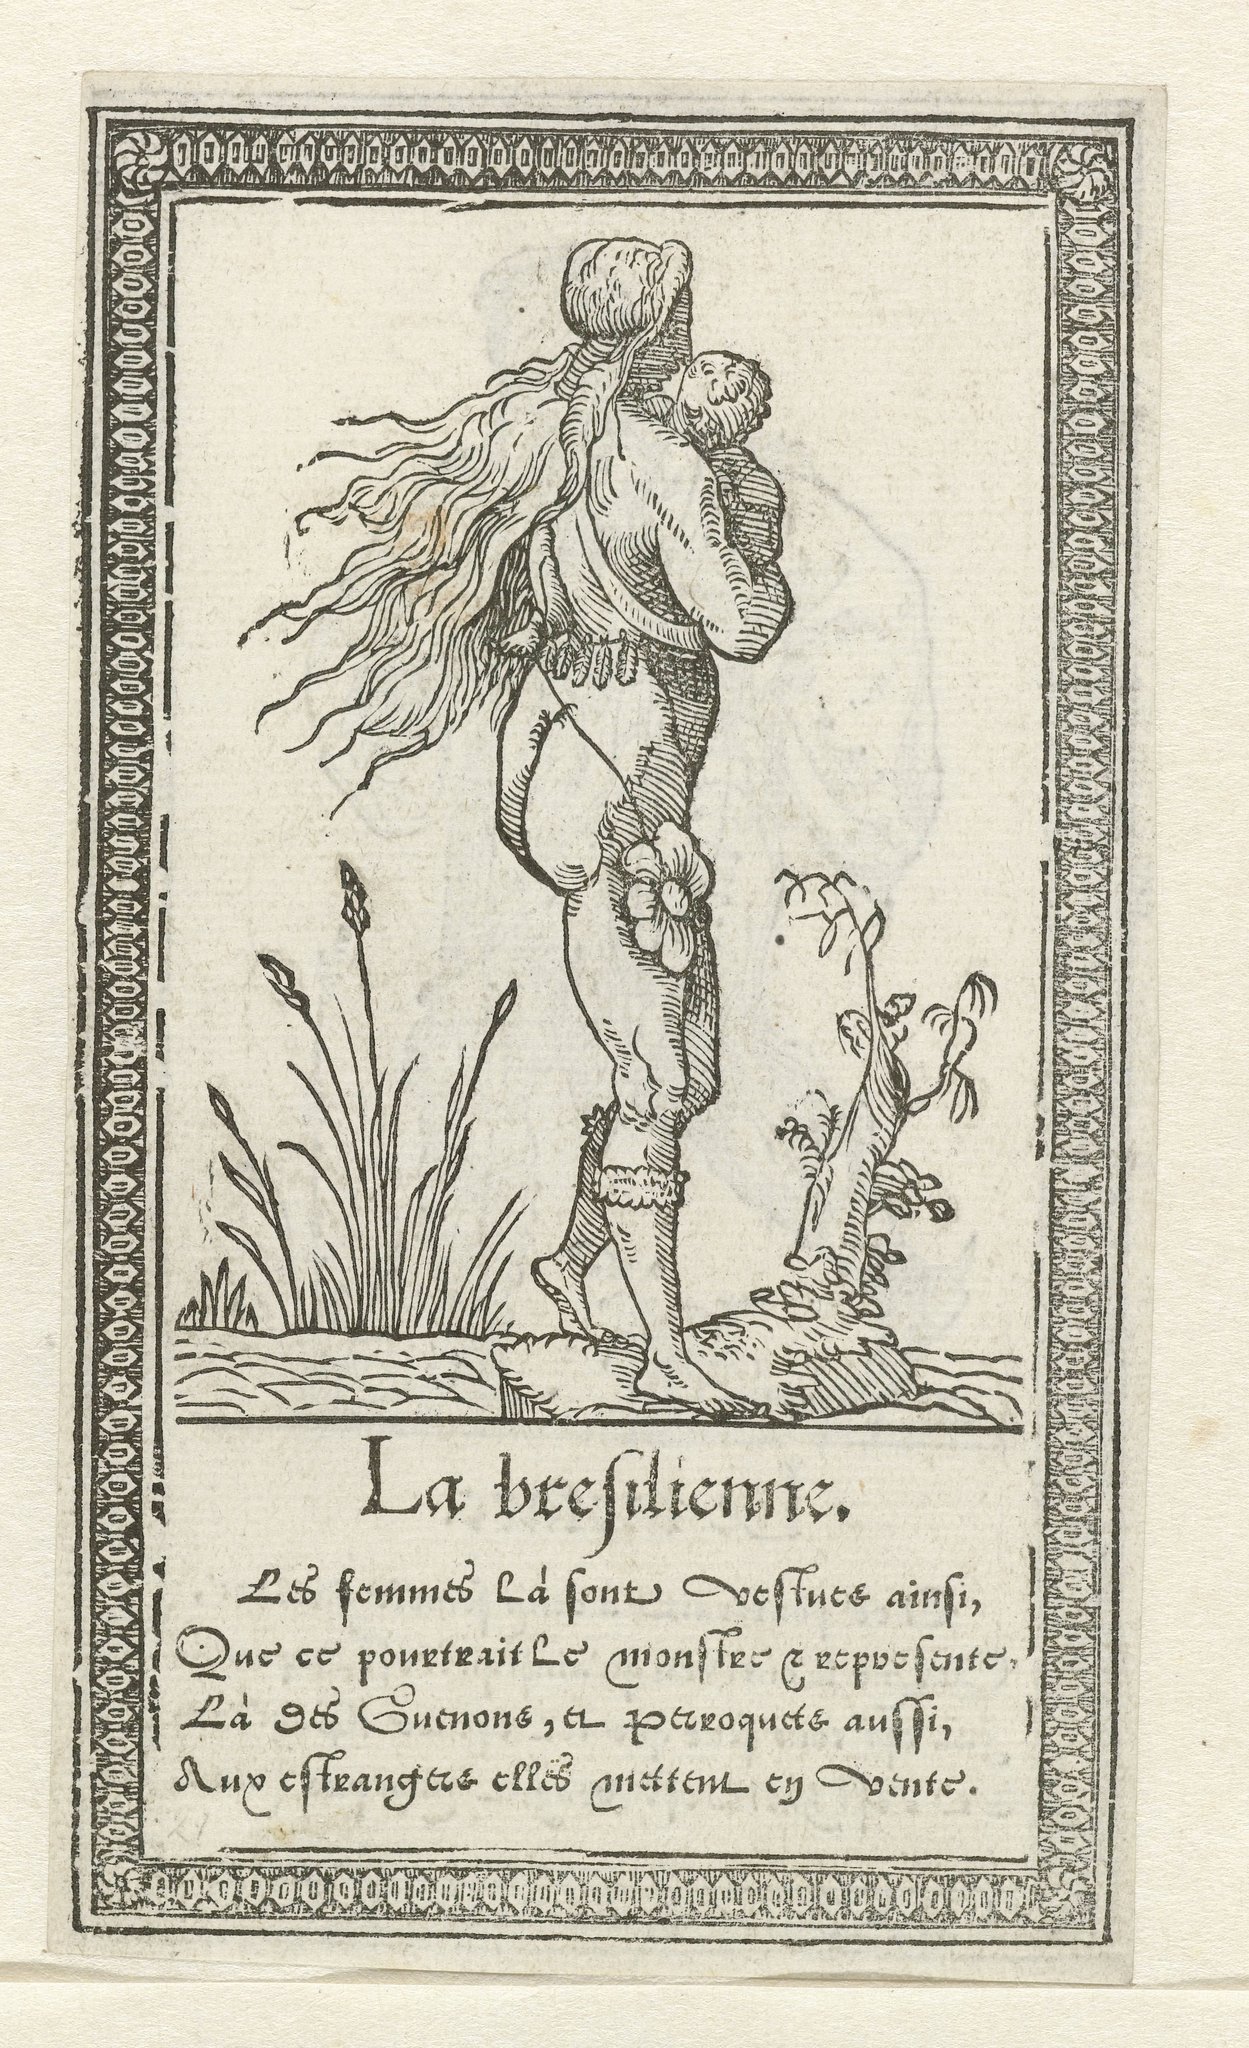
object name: print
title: Recueil de la diversité des habits (A Collection of the Various Styles of Clothing)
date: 1562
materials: paper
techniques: woodcut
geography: paris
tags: indigenous peoples of south america (+ costume), fashion plates, folk costume, regional costume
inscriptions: collector's mark: Lugt 2228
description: This is the very first costume book, with more than a hundred images of clothing from around the world. Below each figure are four lines of verse describing the country’s outfits or related customs. This was an age of unprecedented overseas exploration. Europeans were especially fascinated to see and read about inhabitants of the so-called New World, such as the Brazilian woman with her child 1.